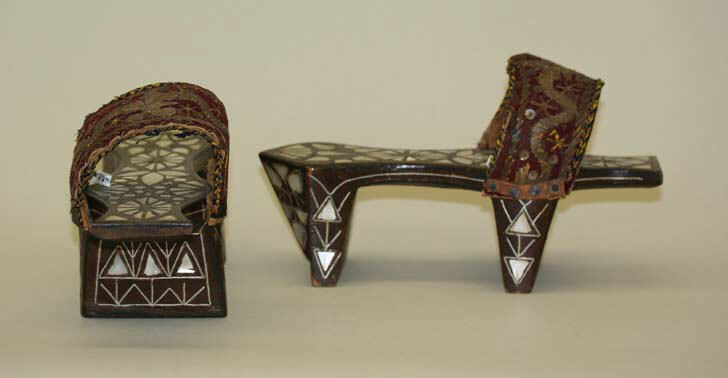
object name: shoe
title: Hammam Shoes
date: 1801-1900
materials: metal, metal thread, mother of pearl, wood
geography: turkey